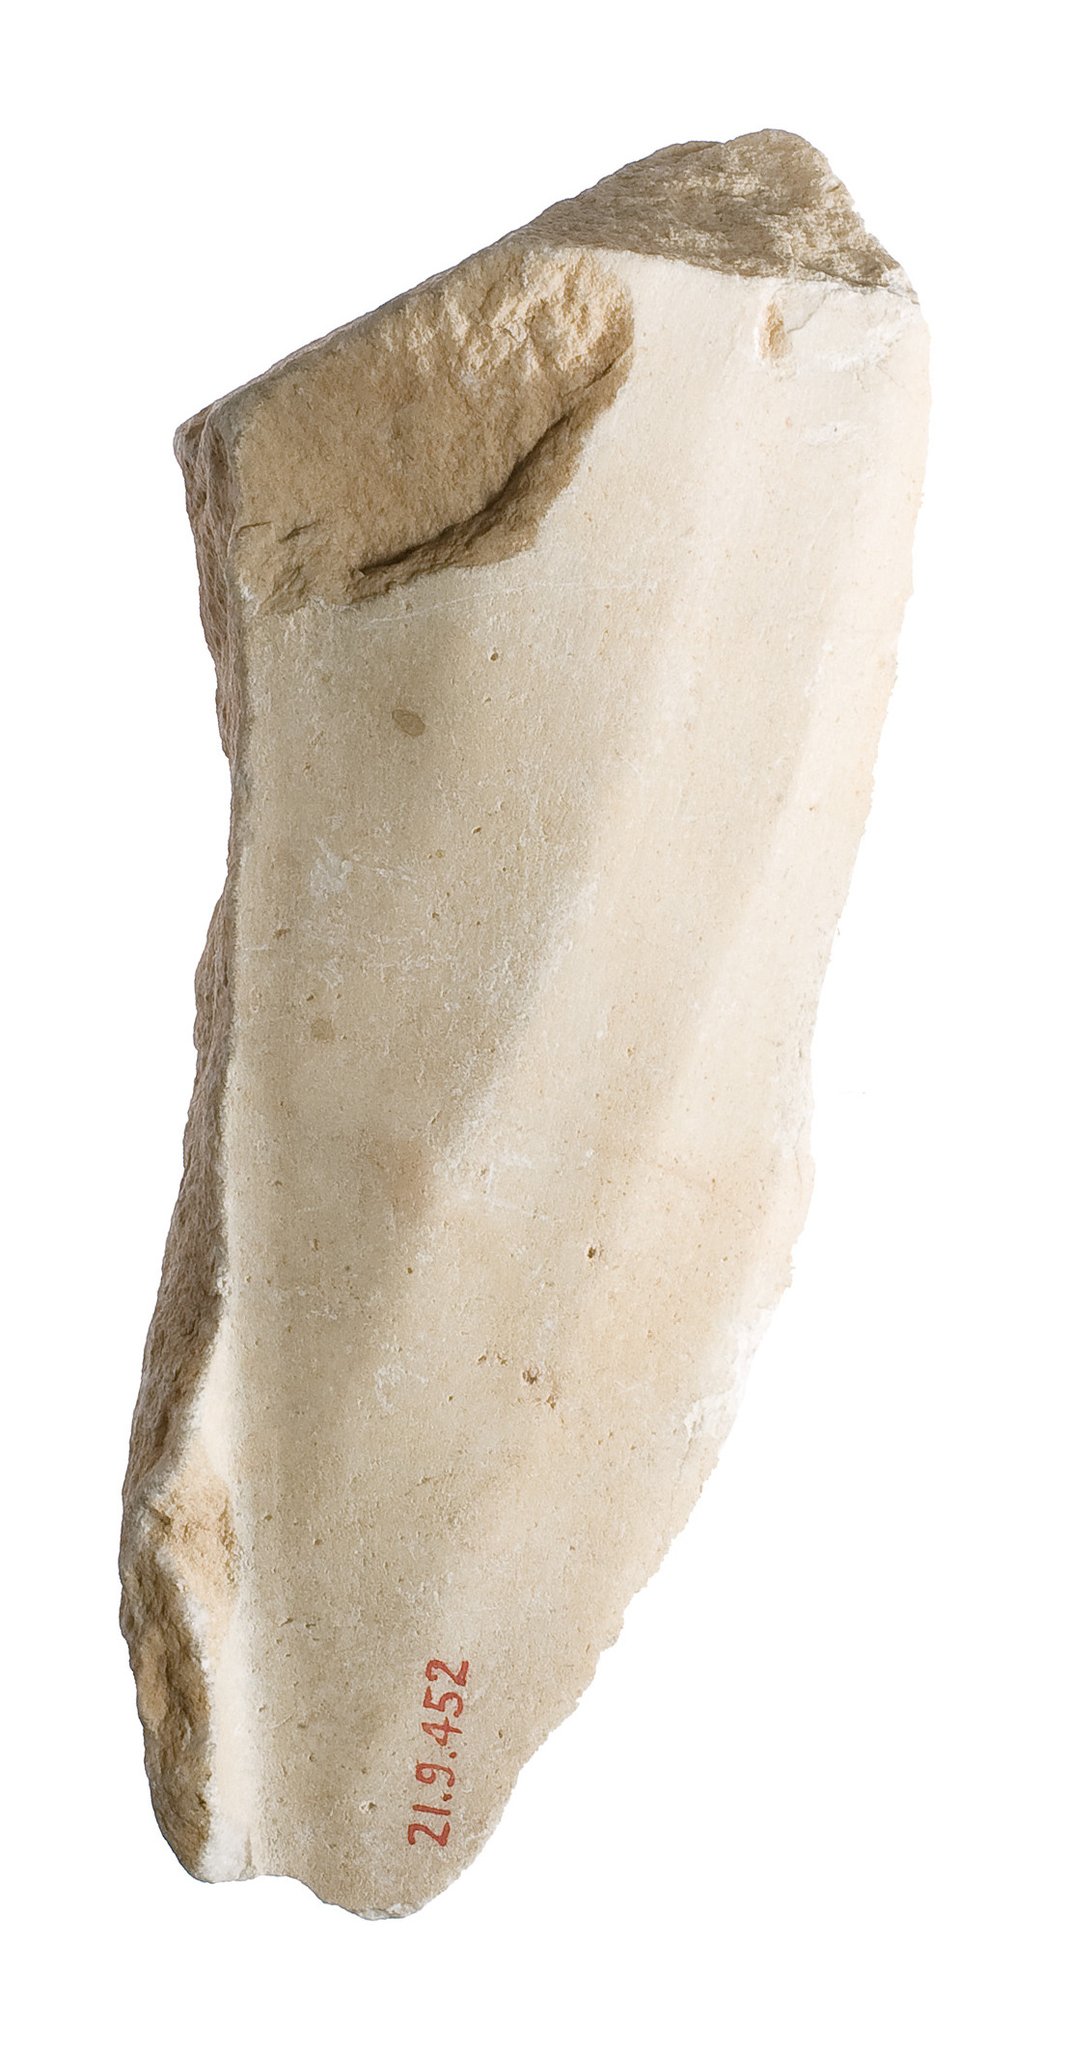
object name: body, pleating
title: Body with garment, pleating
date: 1353-1336 BCE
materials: limestone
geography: egypt